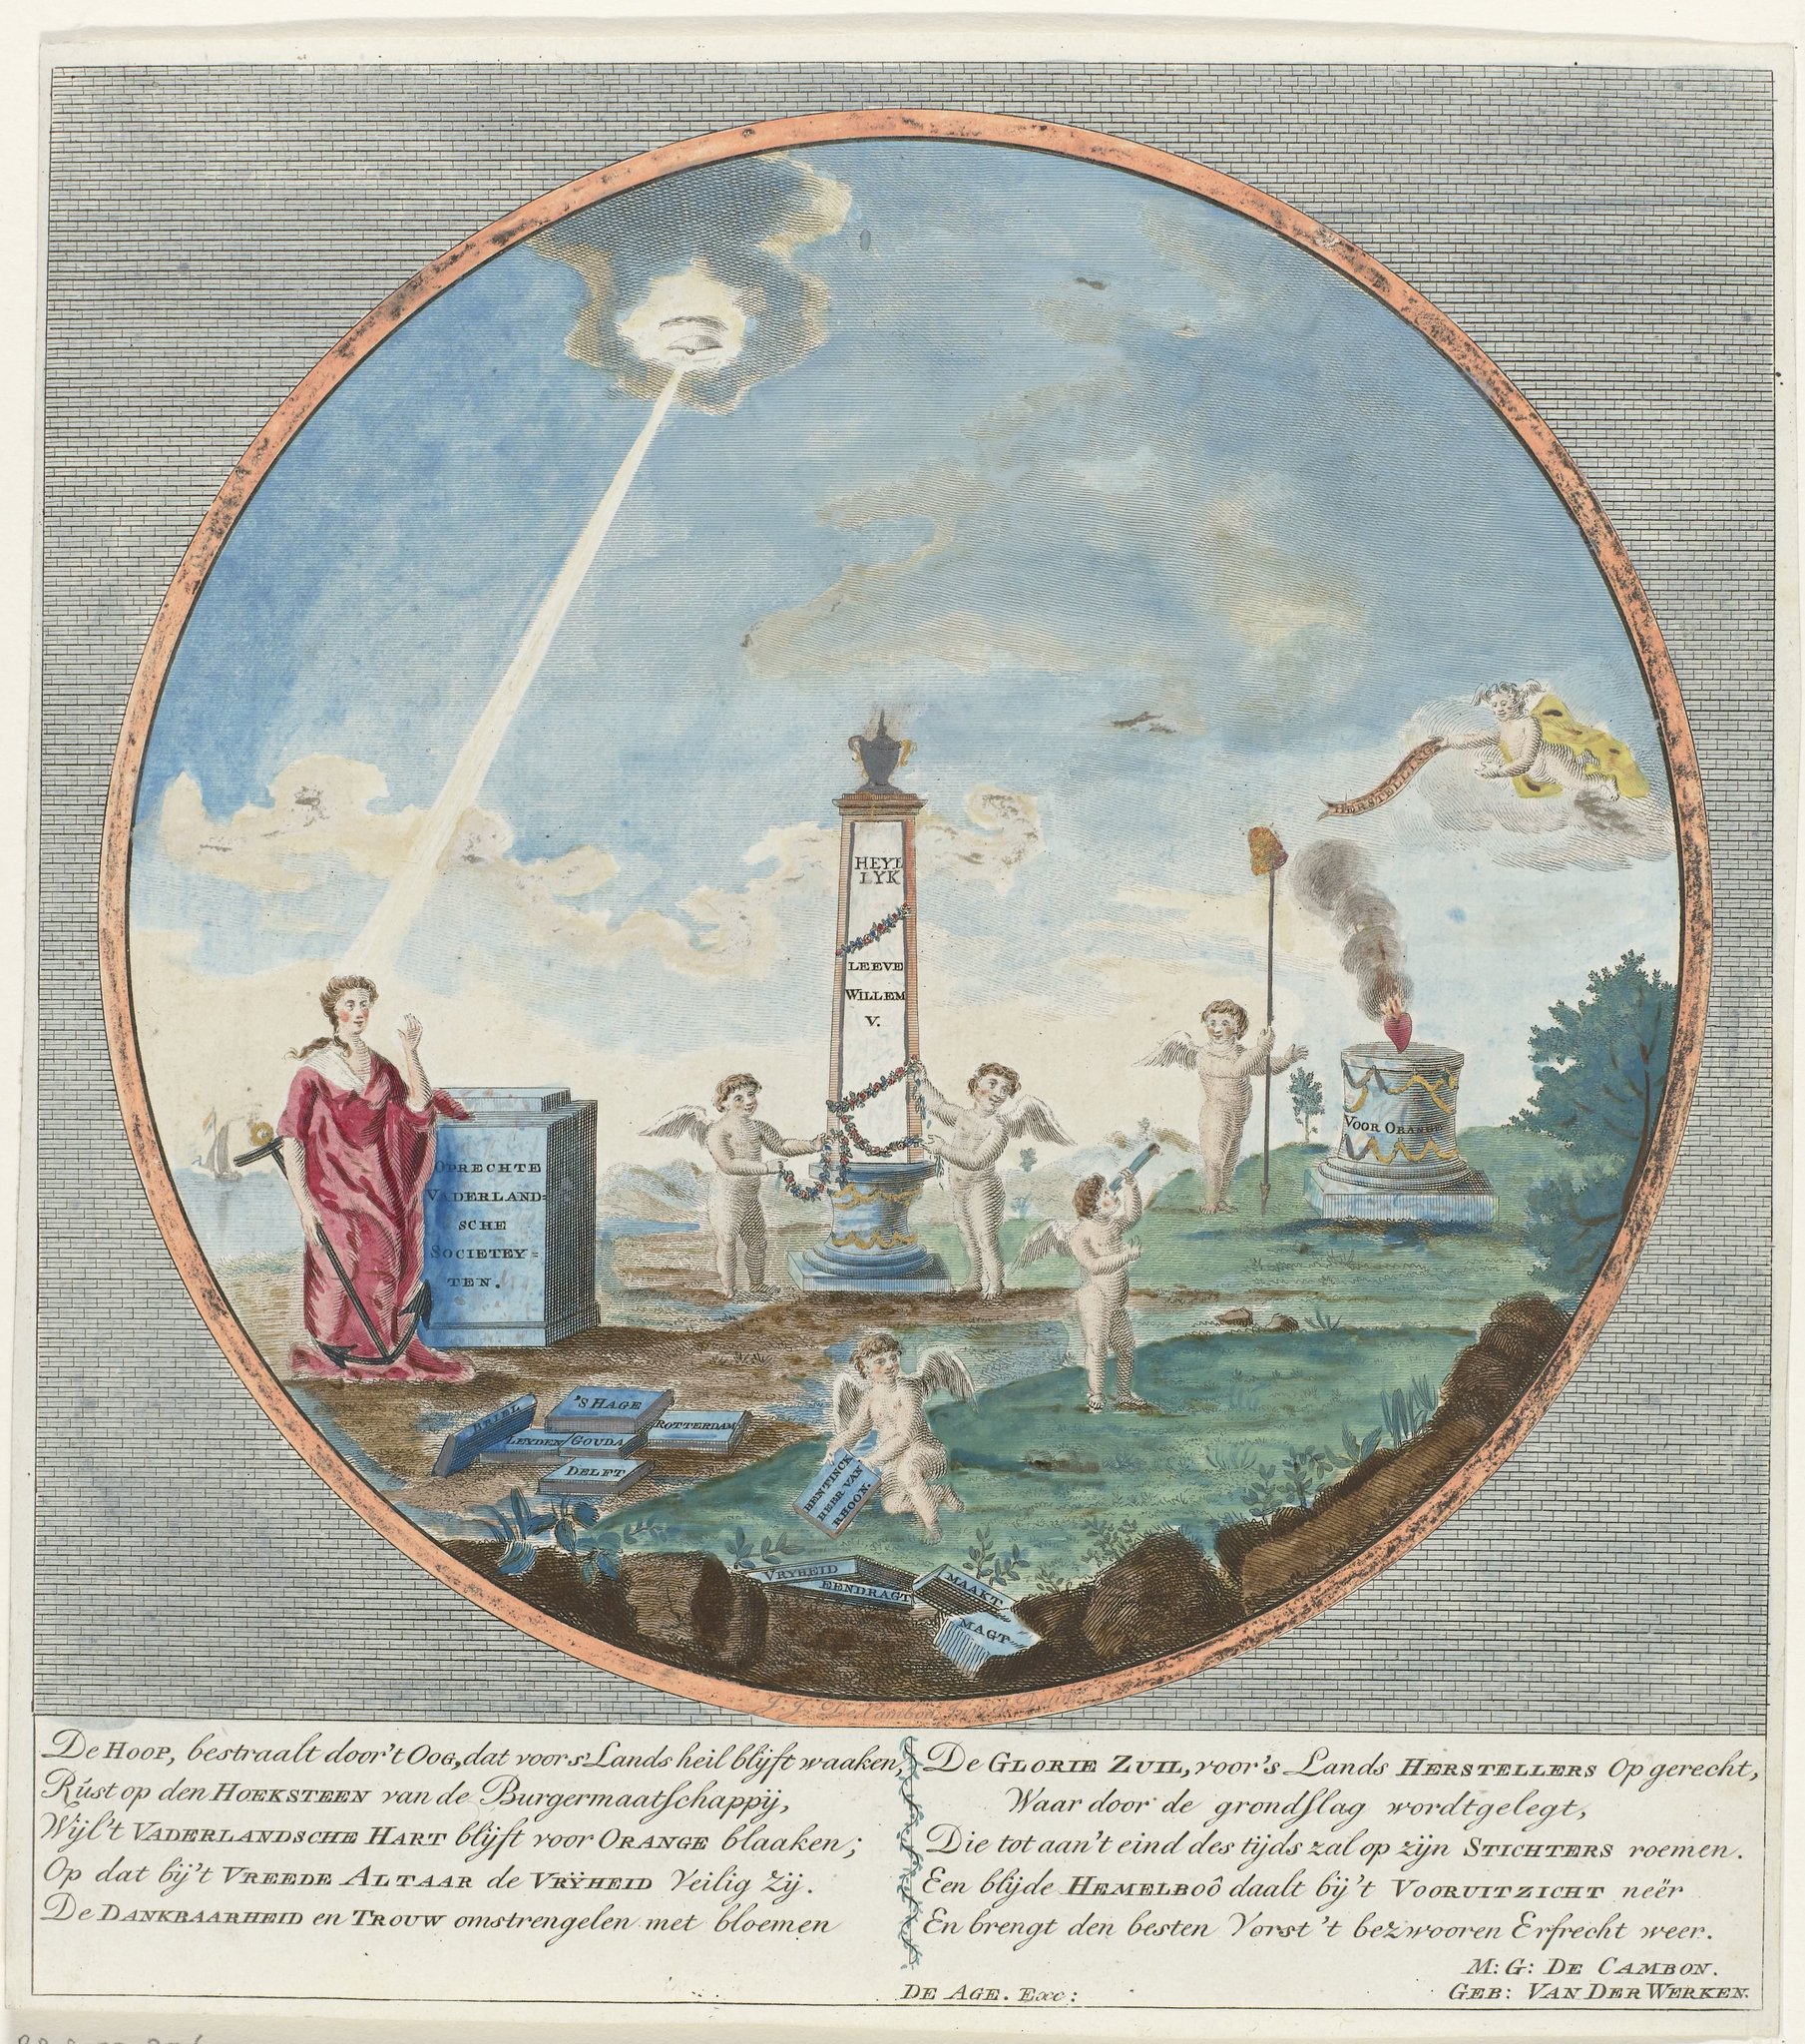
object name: print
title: Allegorie op de oprichting van Oprechte Vaderlandsche Sociëteiten in 1787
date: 1787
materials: paper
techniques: engraving, etching, hand coloring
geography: the hague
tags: william v (prince of orange), hope, 'spes'; 'speranza divina e certa' (ripa) ~ one of the three theological virtues, the all-seeing eye, triangle with eye ~ symbol of god the father, patriots (1780-1795)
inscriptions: collector's mark: Lugt 2228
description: Allegorie op de oprichting van oranjegezinde Oprechte Vaderlandsche Sociëteiten in 1787. Ronde voorstelling met een tuin met de Hoop staande bij een altaar, verder putti bij een monument ter ere van prins Willem V en een altaar "Voor Oranje" waarop een brandend hart. De Hoop wordt beschenen vanuit de hemel door het Hemels Oog. Op de grond boeken met de namen van de plaatsen waar al sociëteiten zijn opgericht: Den Haag, Rotterdam, Delft, Gouda, Leiden en Brielle. In het onderschrift een vers van tien regels.